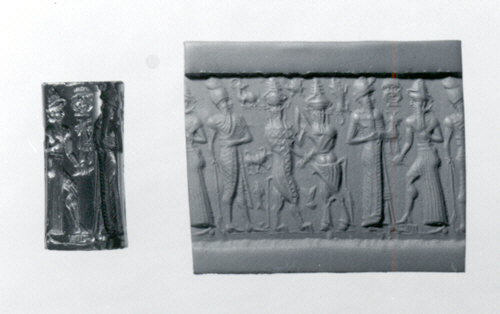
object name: cylinder seal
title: Cylinder seal and modern impression: worshiper and the sun god; king; bull-man and a lion-man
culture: babylonian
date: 1800-1701 BCE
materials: mineral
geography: mesopotamia or syria